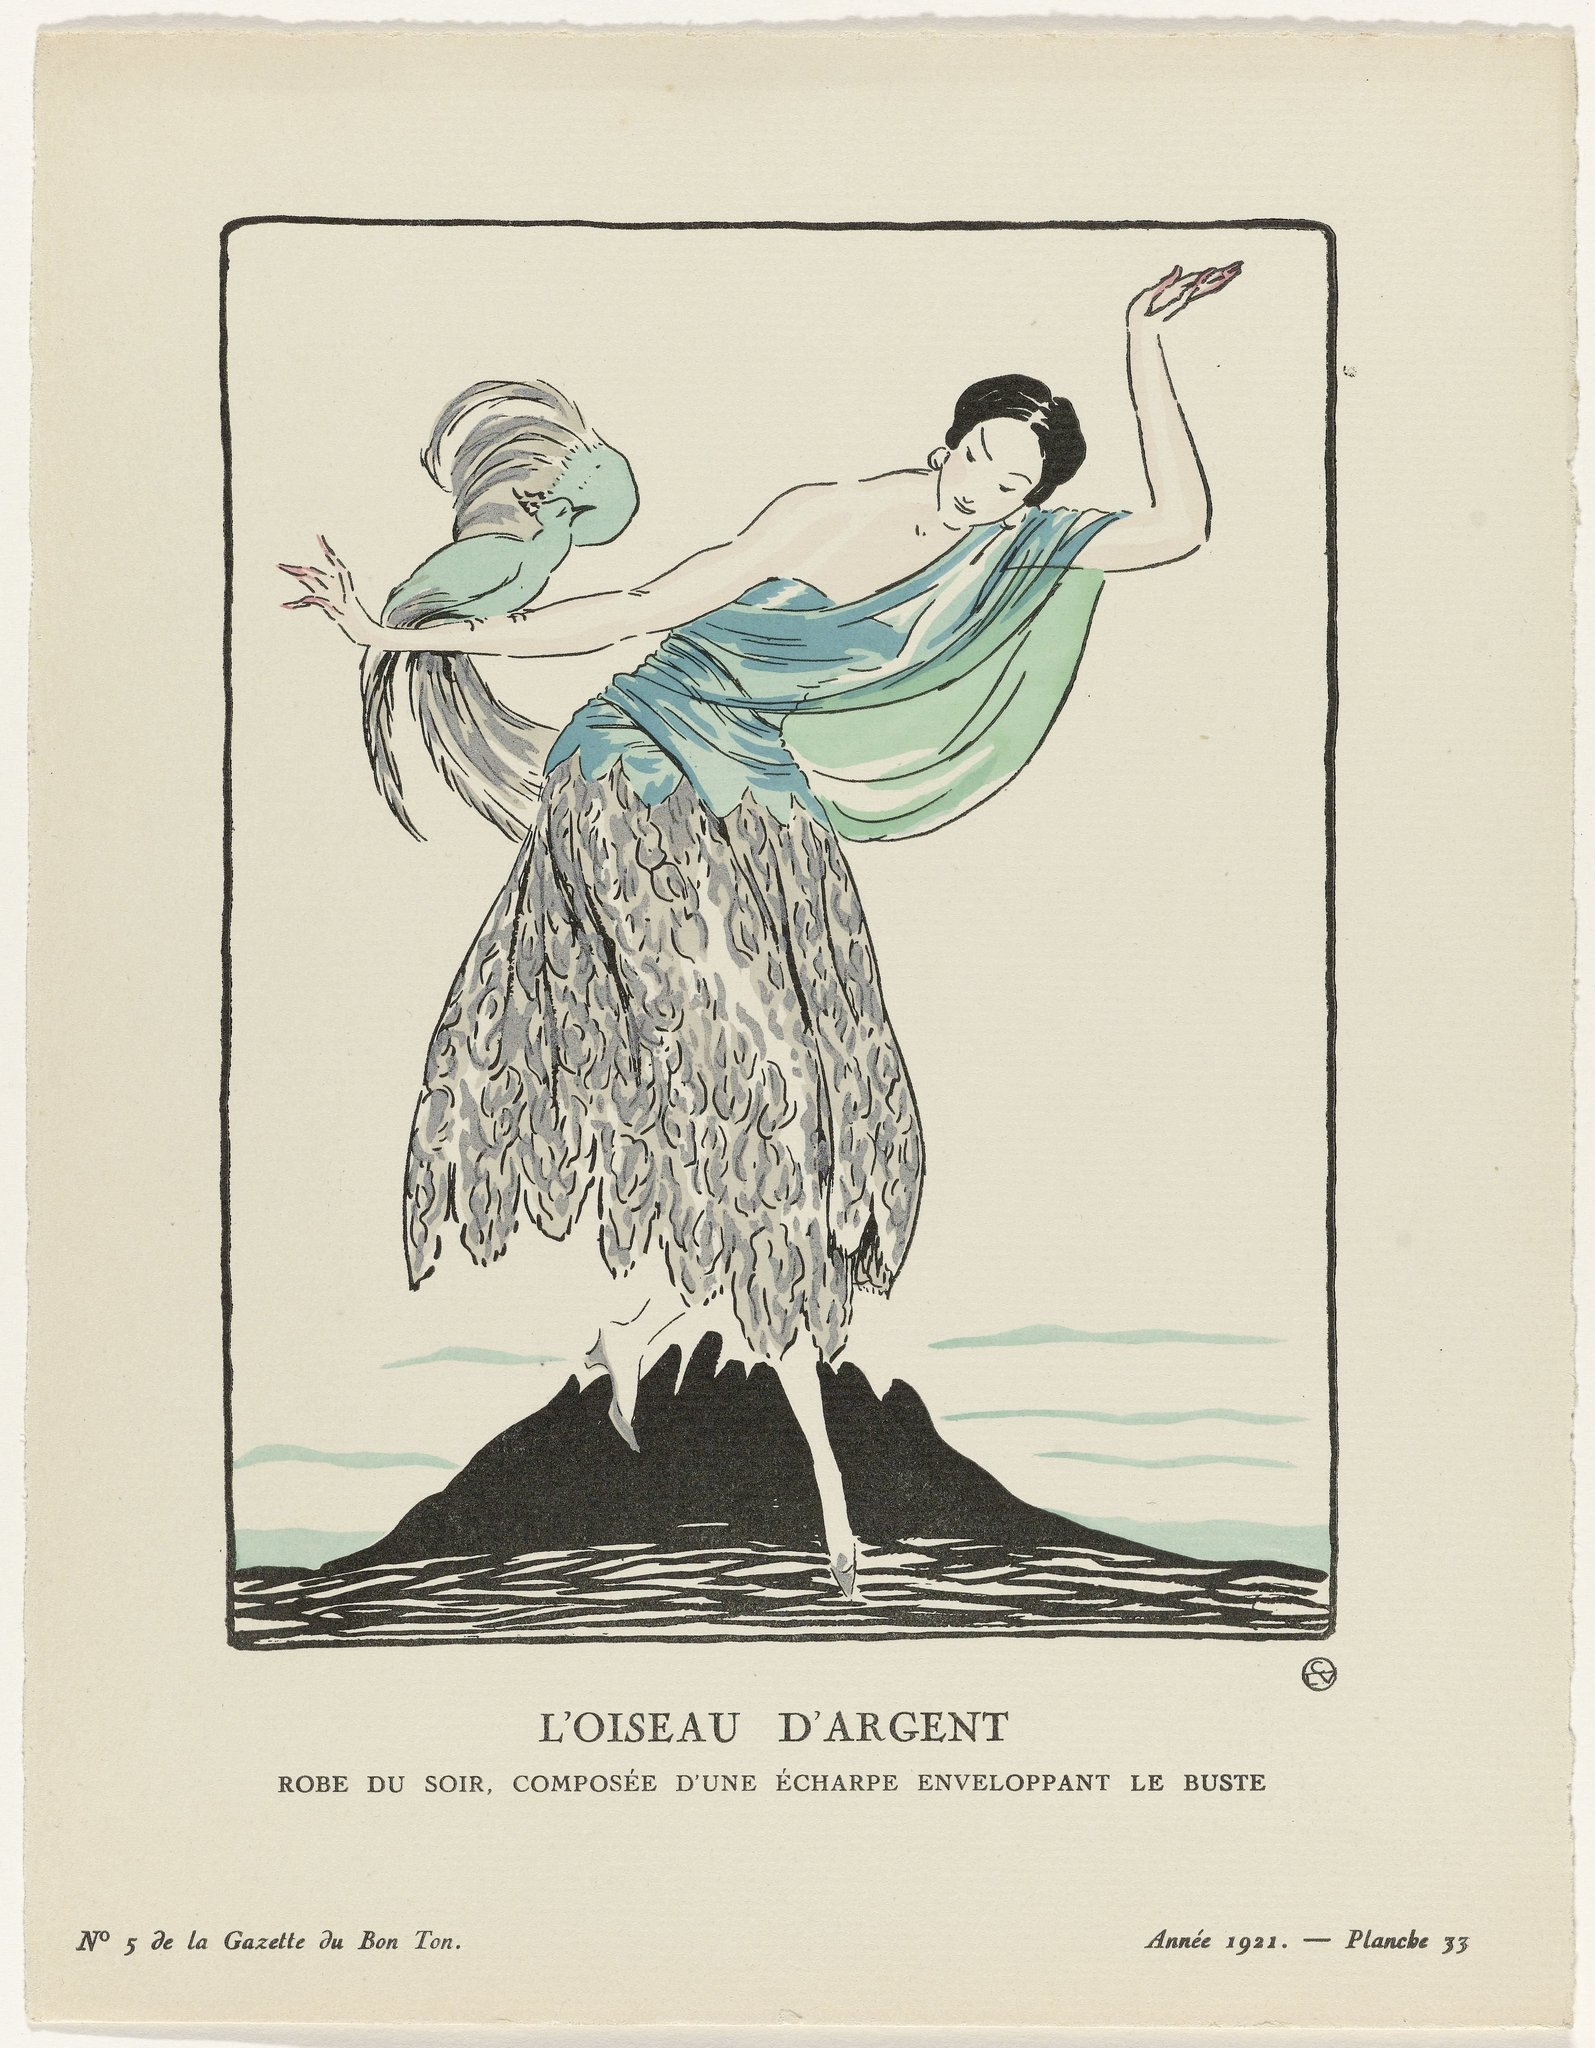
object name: fashion print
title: Gazette du Bon Ton, 1921 - No. 5 : L'oiseau d'argent / Robe du soir, composée d'une écharpe enveloppant le buste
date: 1921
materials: paper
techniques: hand coloring, letterpress printing, lithograph, pochoir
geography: buenos aires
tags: dress, gown: evening dress (+ women's clothes), clothing for the upper part of the body (shawl) (+ women's clothes), lace (+ materials used for clothes), birds, fashion plates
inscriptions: date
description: Lopende vrouw met een vogel op de arm. Zij draagt een avondjapon met een zilverkleurige rok van kant en een lijfje bestaande uit een omwikkelde sjaal. Planche 33 uit Gazette du Bon Ton 1921, No. 5. Uitleg over de kleding op pagina "Explication des Planches Hors-Texte. Contenues dans ce numéro".